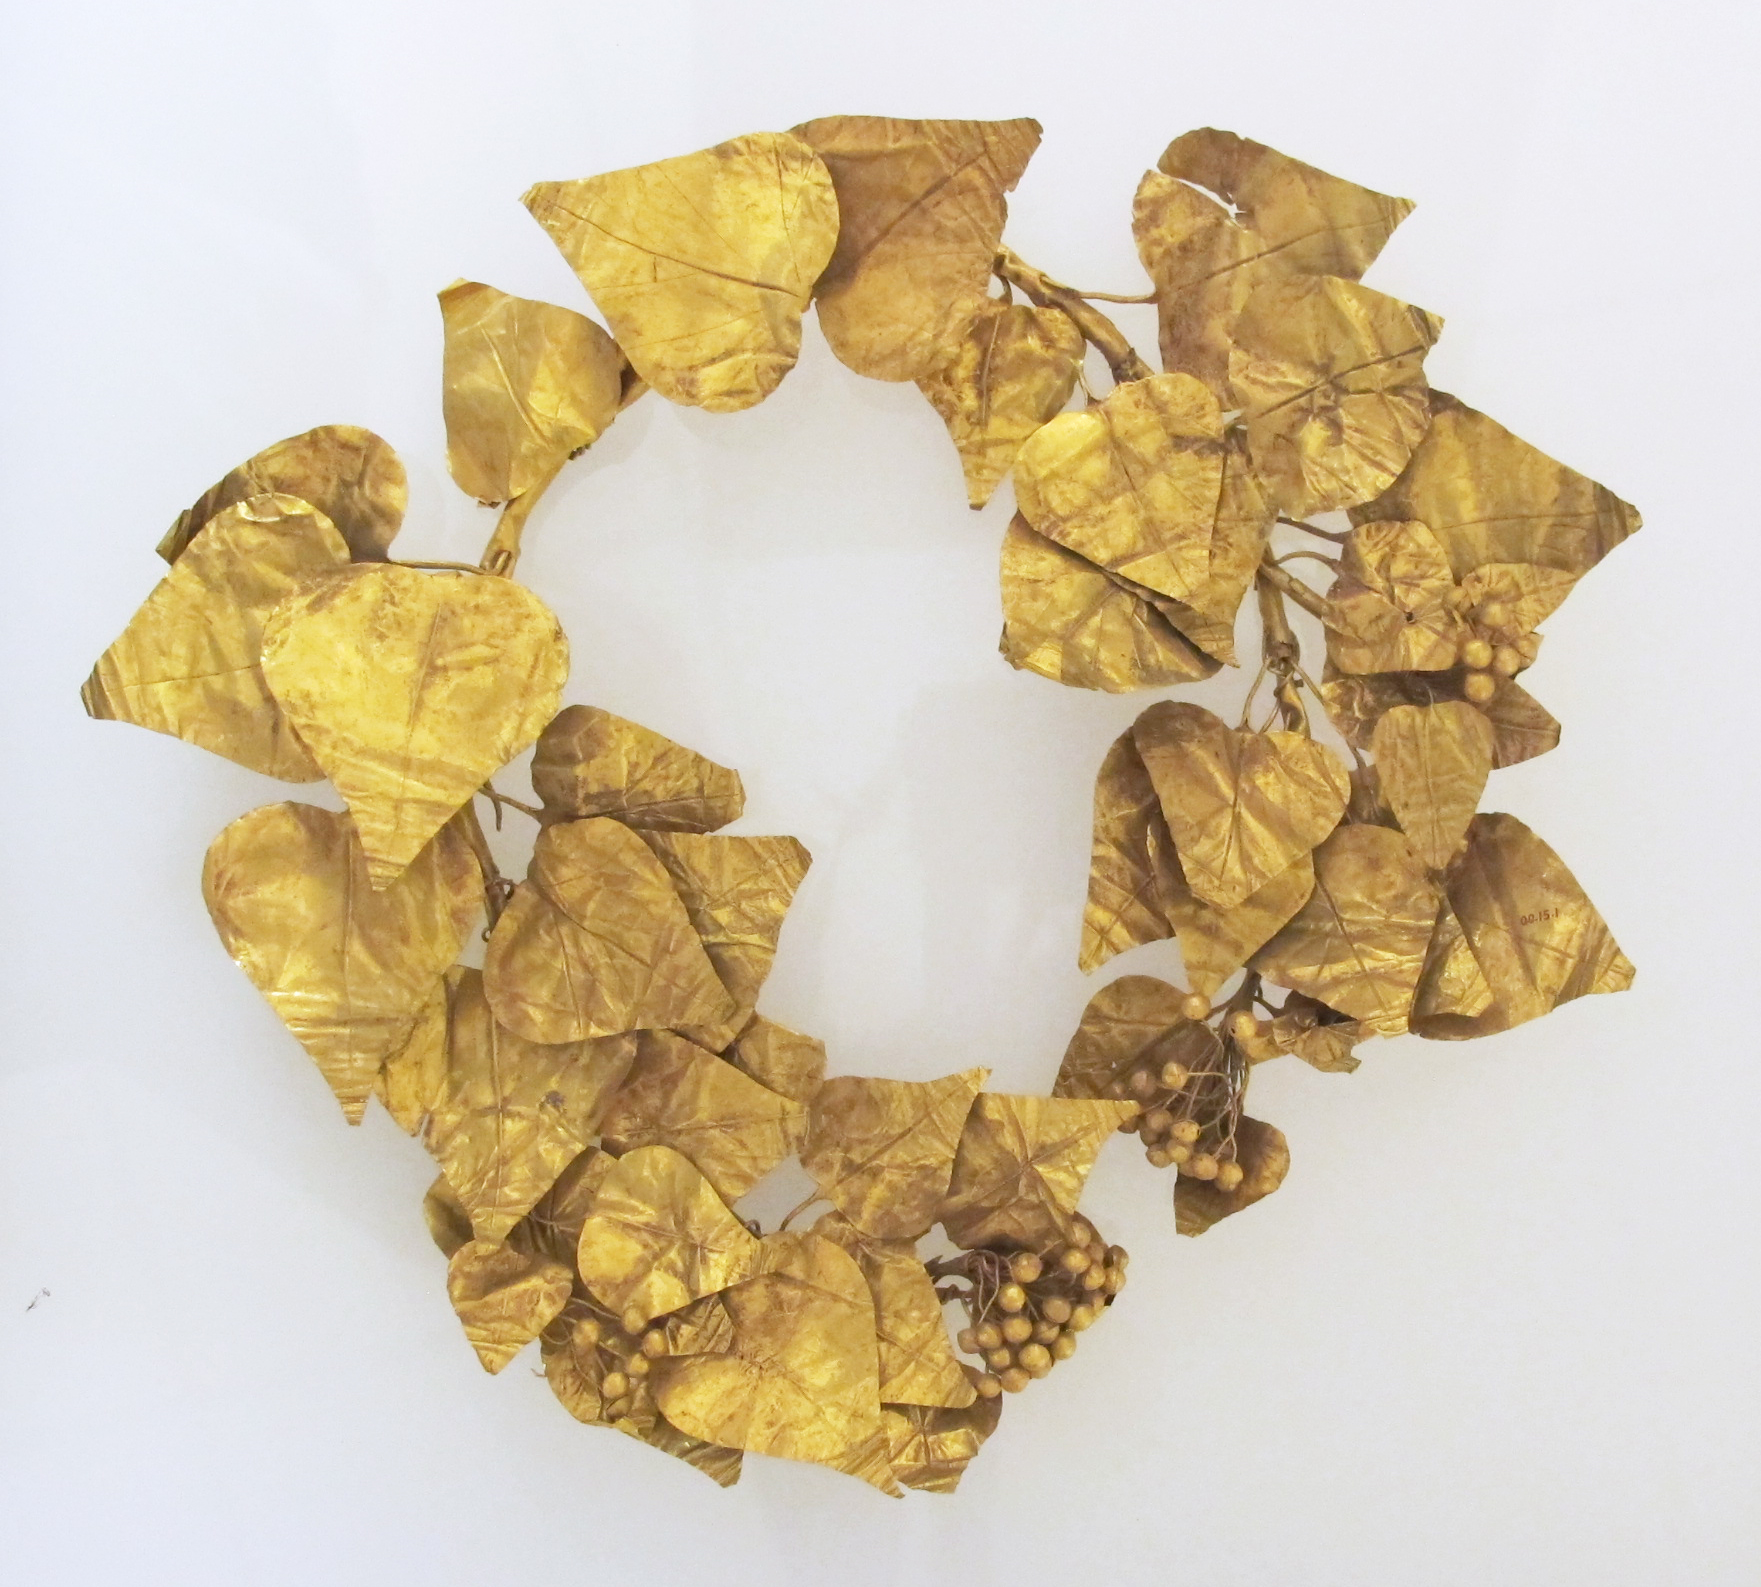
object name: wreath of ivy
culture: roman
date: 670 BCE-330 CE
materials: gold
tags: leaves,wreaths